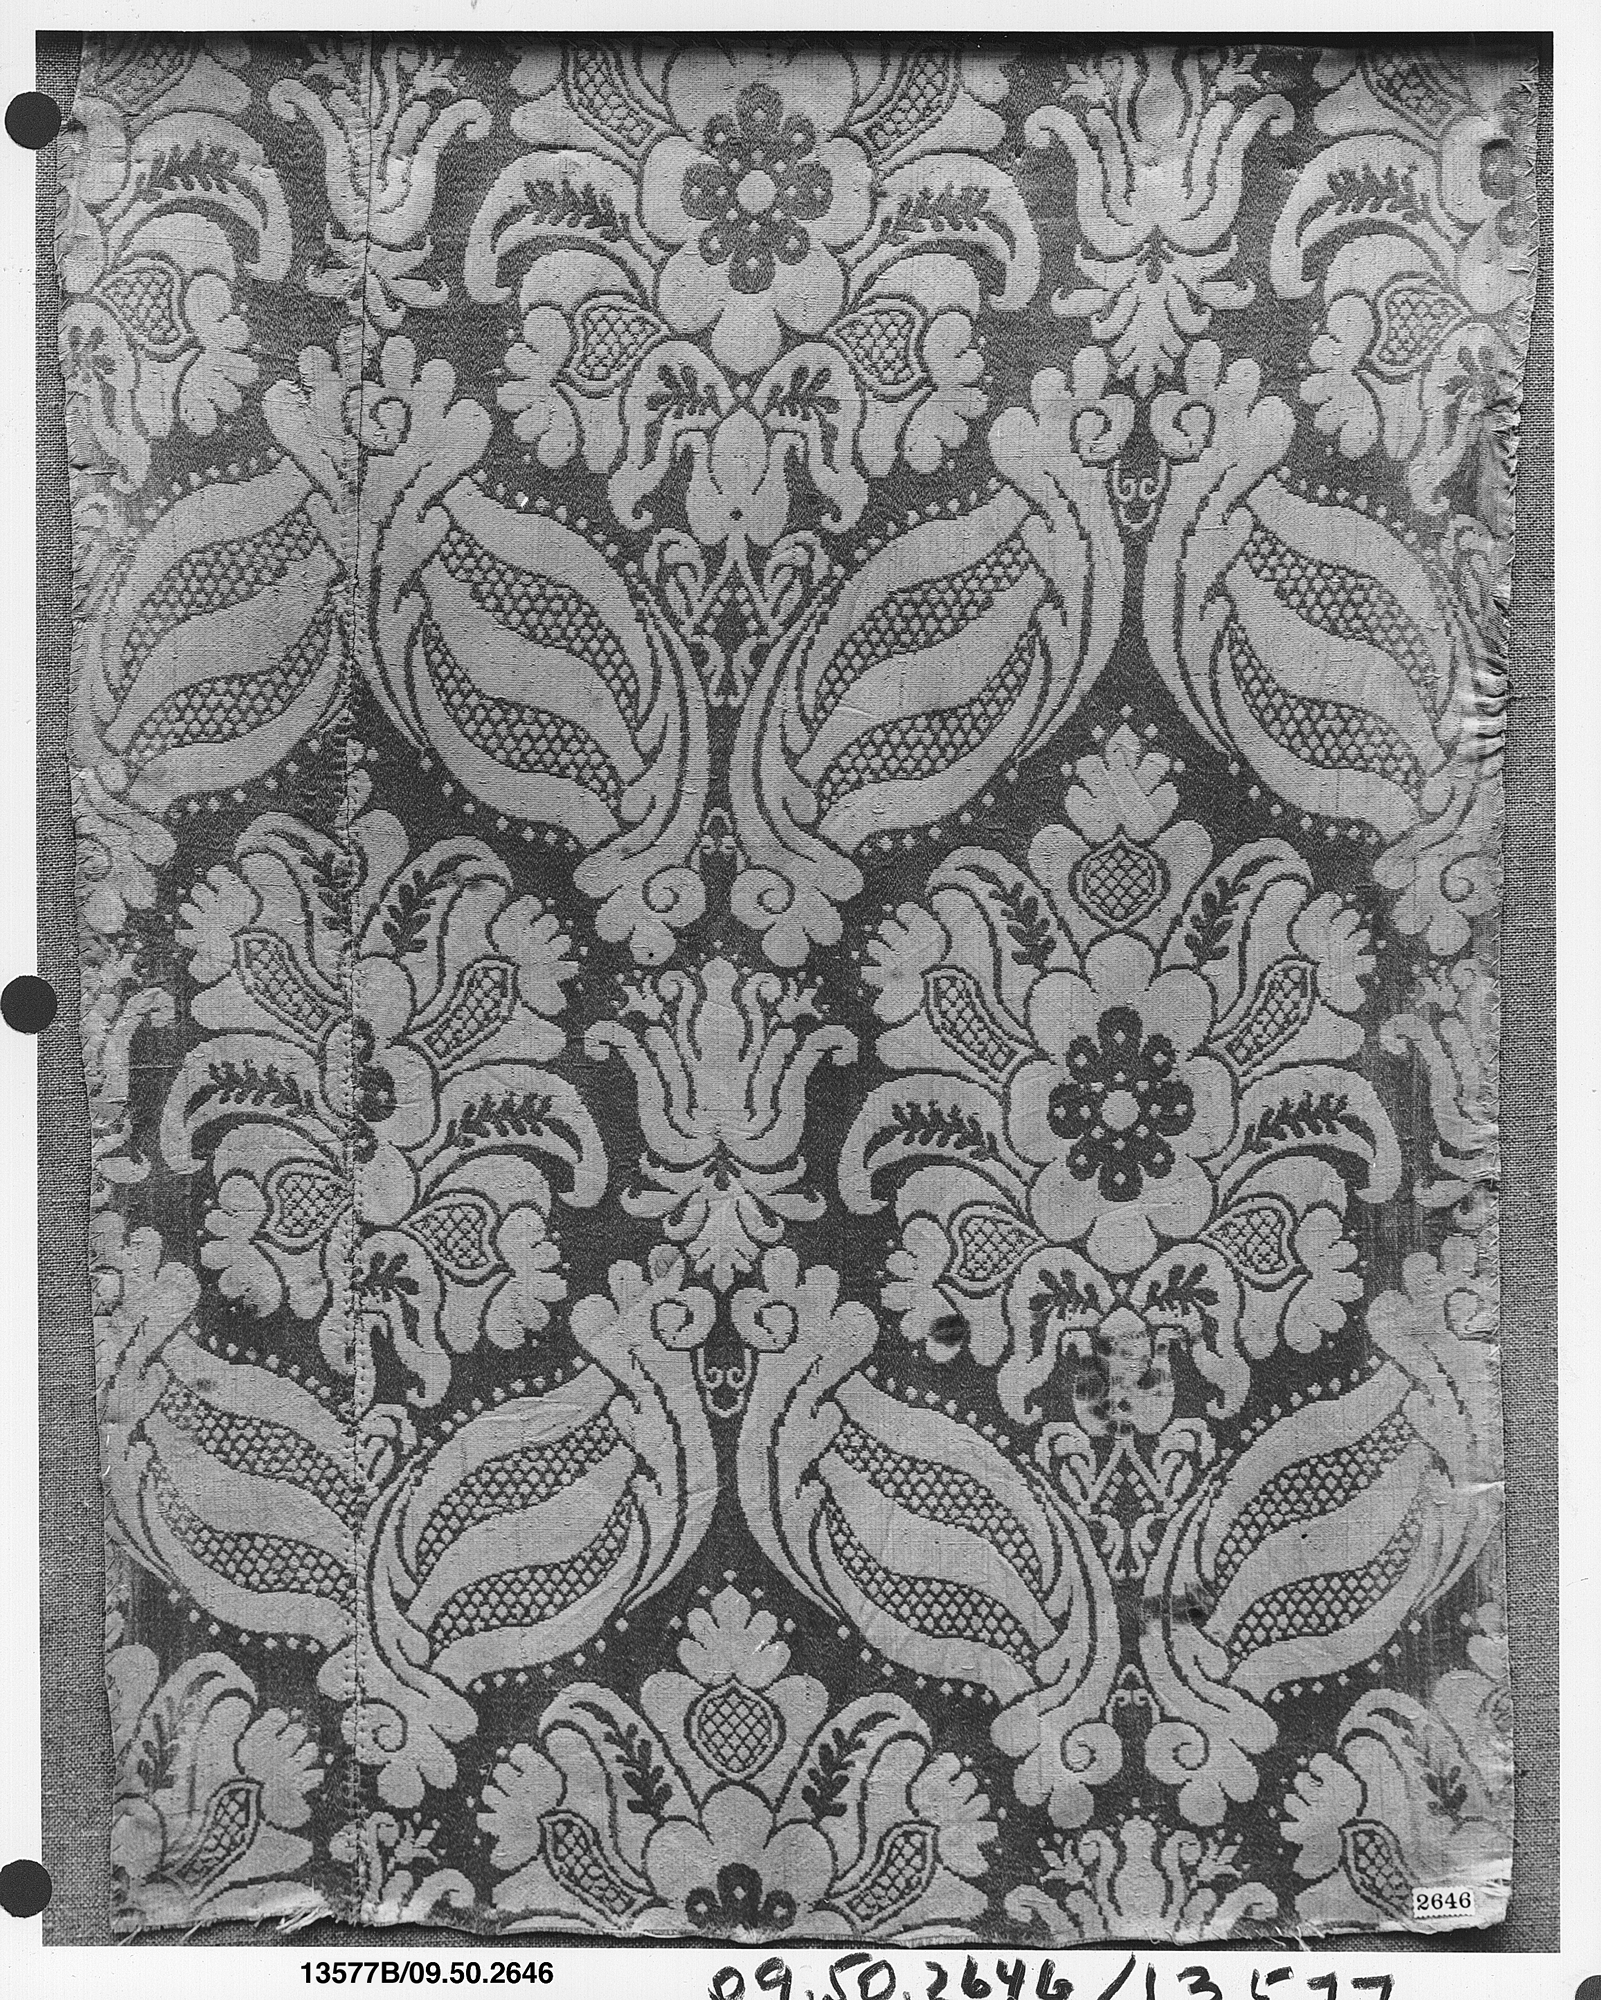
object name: piece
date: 1701-1733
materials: silk